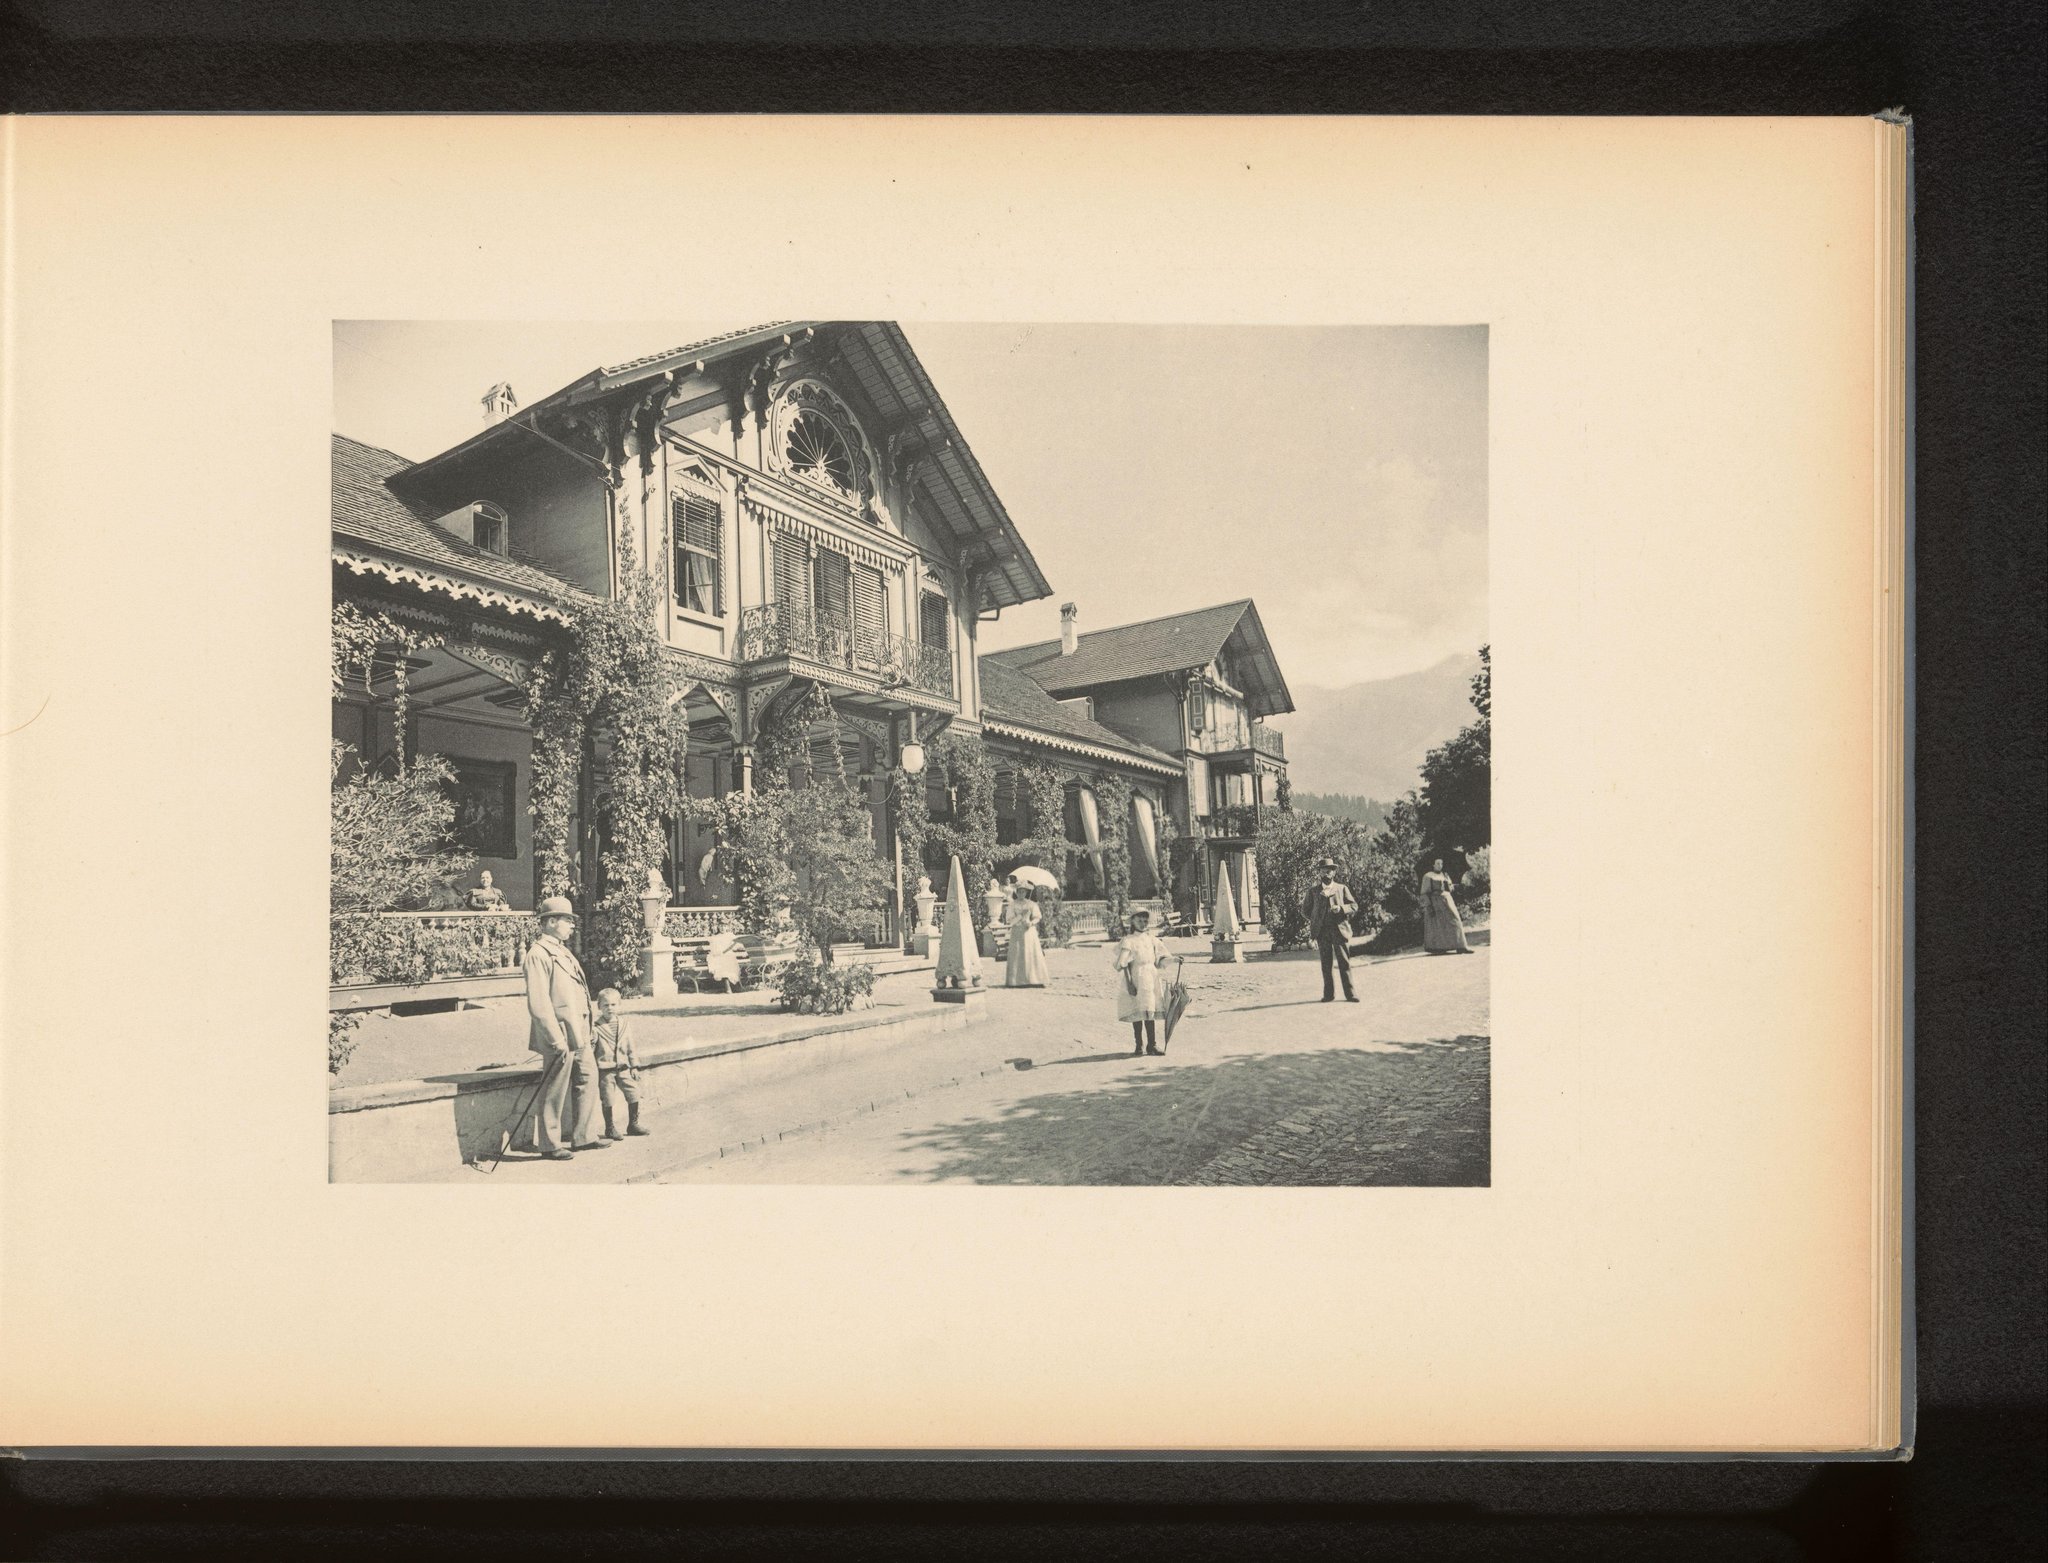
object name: page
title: Gezicht op de promenade voor het hoofdgebouw van de baden van Heustrich-les-bains bij Spiez, Zwitserland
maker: Anonymous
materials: paper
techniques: photograph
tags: public baths, avenue, boulevard, promenade, esplanade